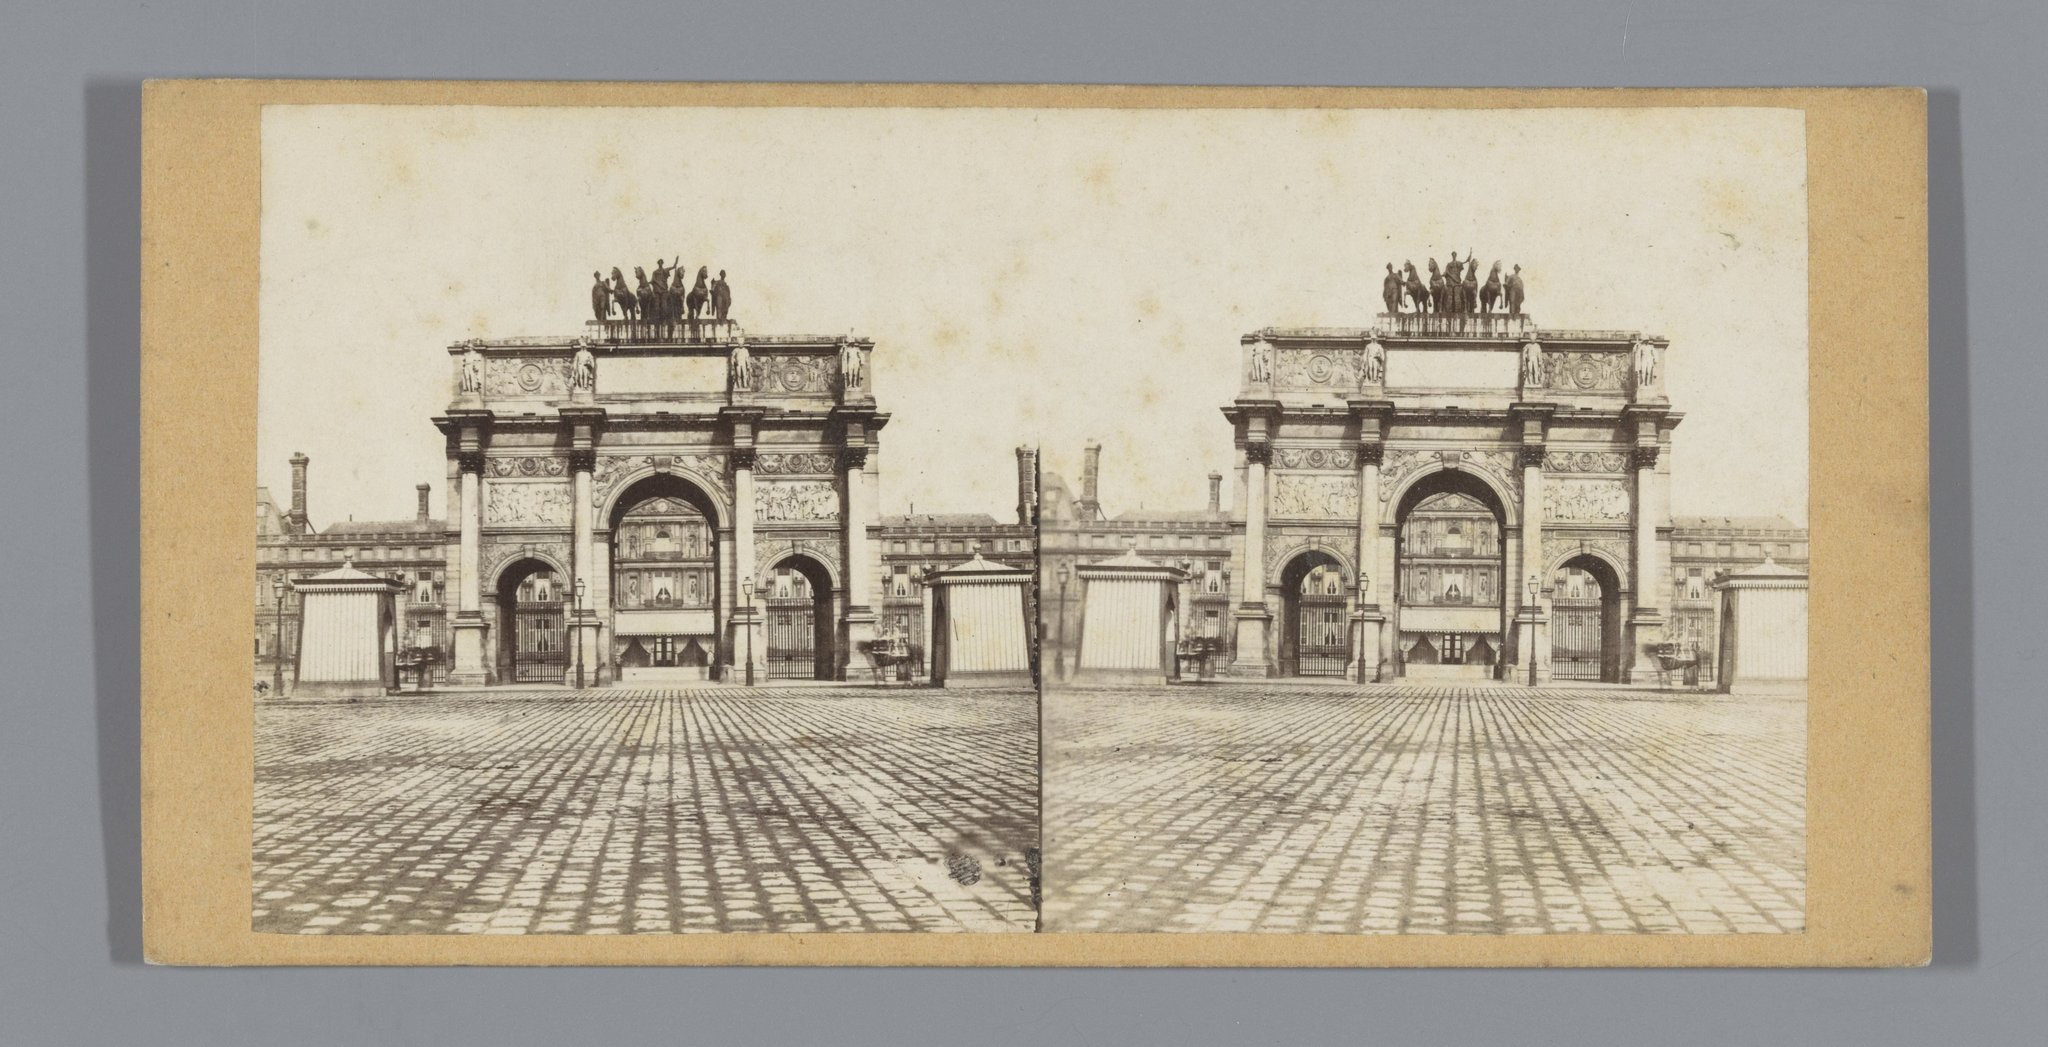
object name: stereograph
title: Gezicht op de Arc de Triomphe du Carrousel te Parijs, met op de achtergrond het Palais des Tuileries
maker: Anonymous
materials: cardboard, photographic support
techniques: albumen print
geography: place du carrousel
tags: square, place, circus, etc., triumphal arch, palace